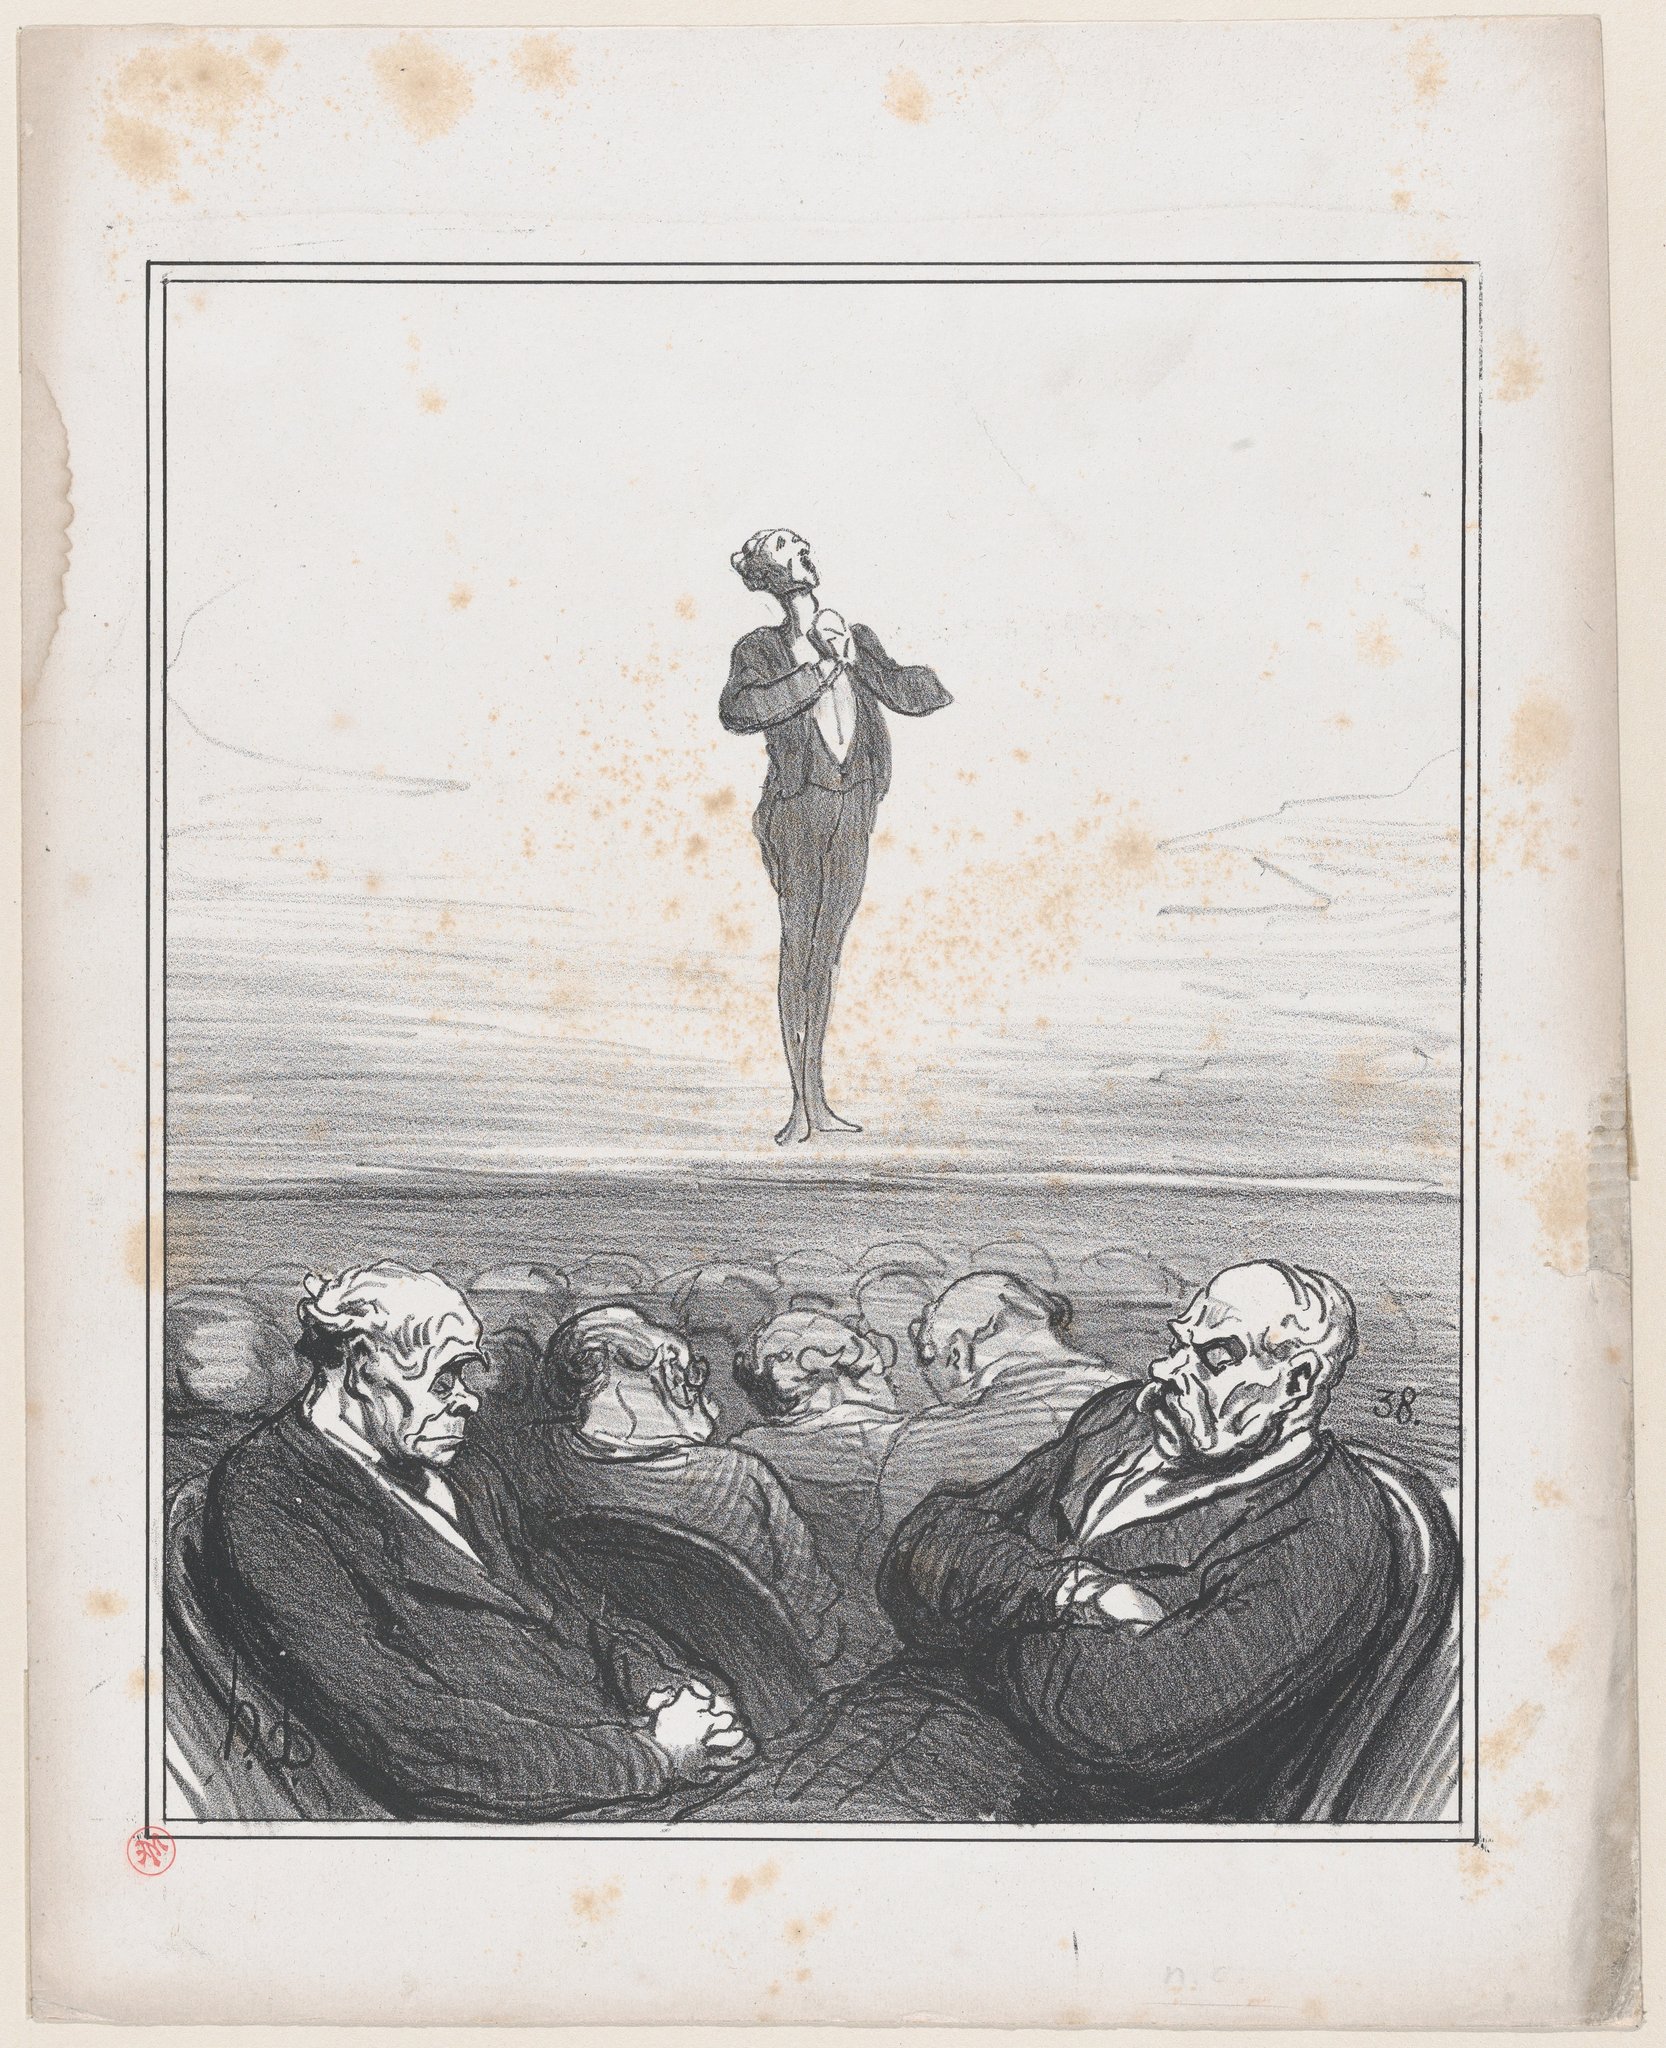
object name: print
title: The competition at the conservatory: At the 79th audition of "Oh, what a pleasure to be a soldier!", from 'News of the day,' published in "Le Charivari"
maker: honoré daumier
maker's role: artist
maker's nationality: french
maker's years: 1808-1879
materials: paper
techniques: lithograph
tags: satire,men